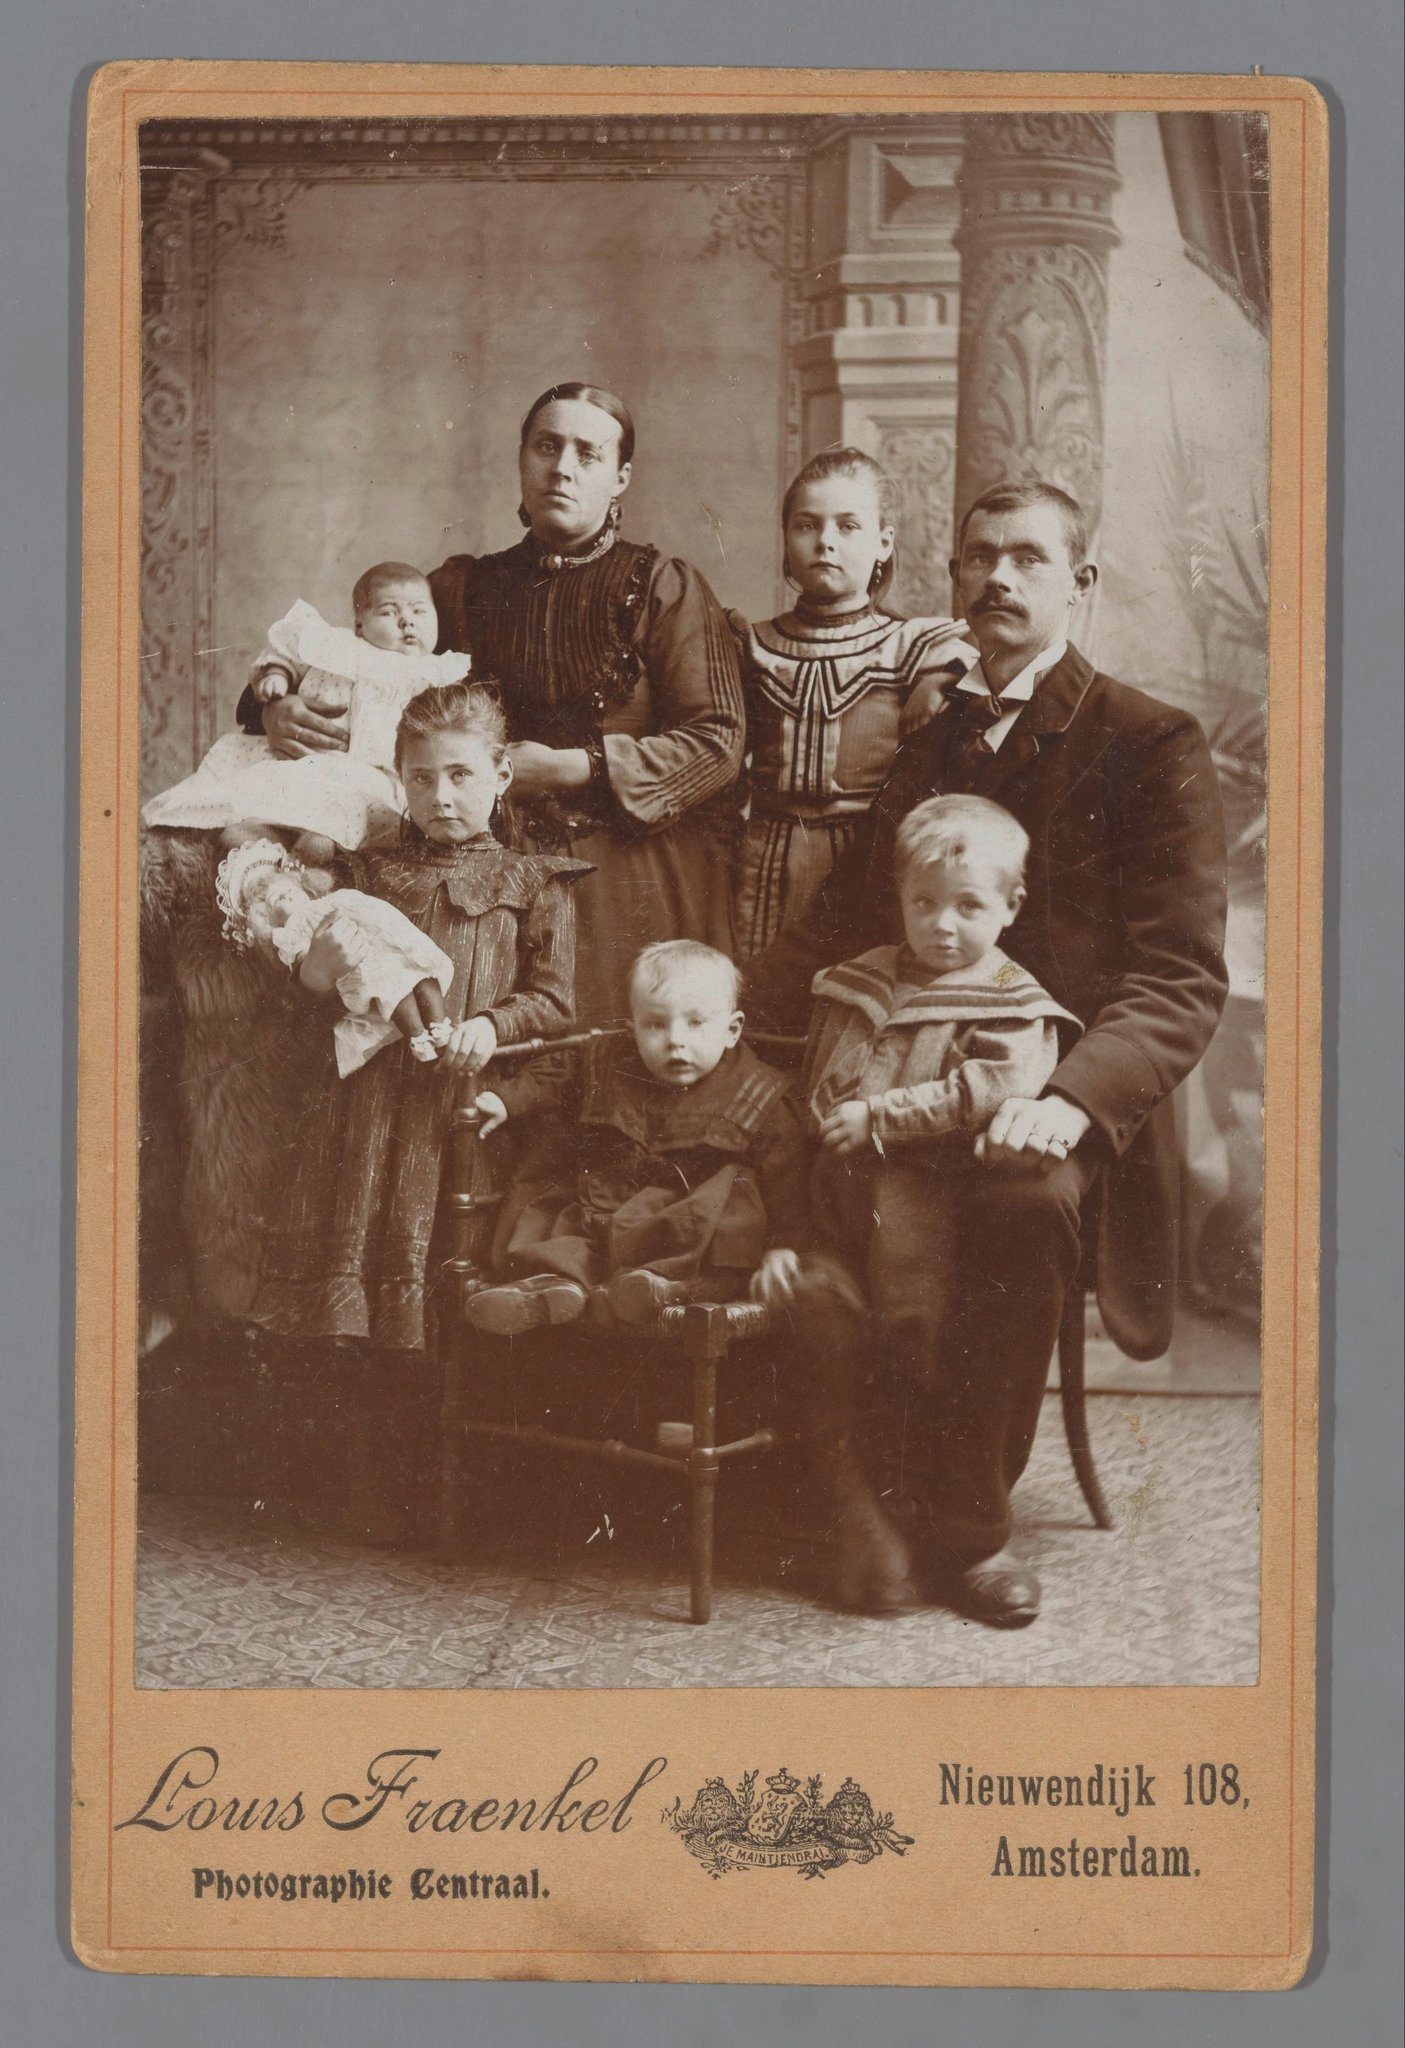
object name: cabinet photograph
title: Groepsportret van vermoedelijk een familie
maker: louis fraenkel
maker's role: fotograaf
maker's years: 1842-1929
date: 1878-1929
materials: cardboard, photographic support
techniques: collodion silver print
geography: amsterdam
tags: studio requisites ~ photographer, family, descendance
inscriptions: name: ‘Louis Fraenkel Photograhie Centraal Nieuwendijk 108. Amsterdam.’